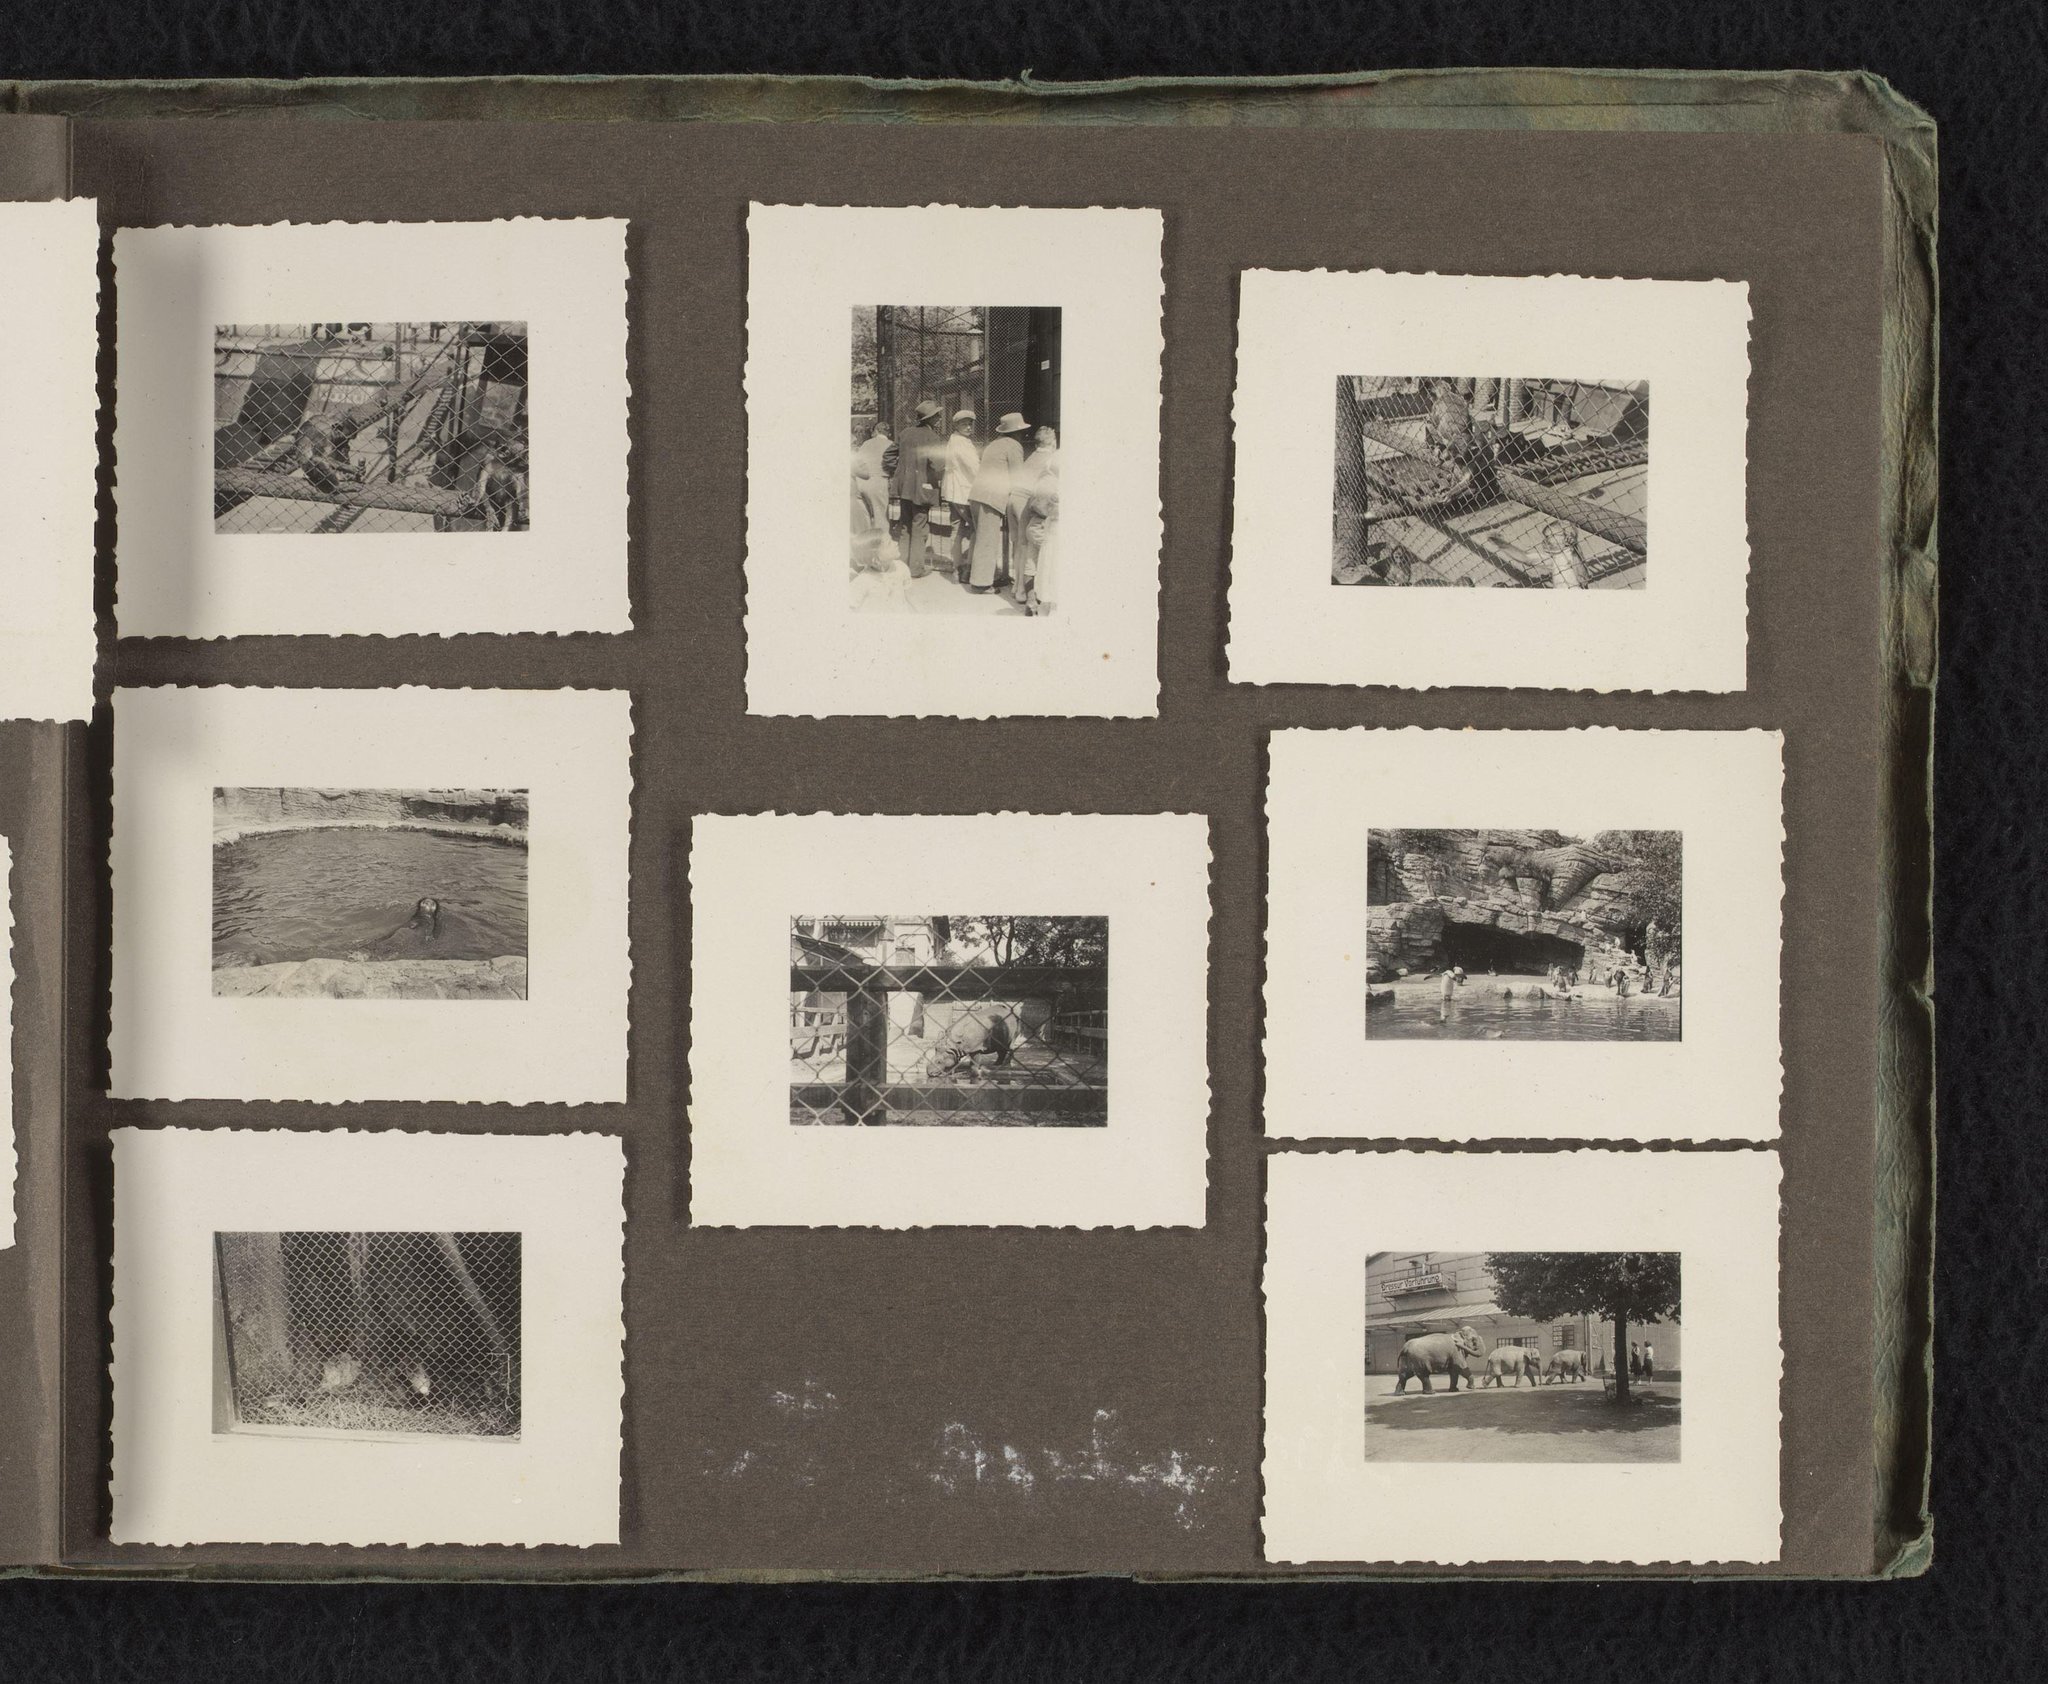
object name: photograph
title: Dieren in dierentuin Hagenbeck, juli 1933, Hamburg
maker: else wachenheimer-moos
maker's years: 1895-1944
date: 1907-1933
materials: paper, photographic support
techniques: gelatin silver print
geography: hamburg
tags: the family travelling, on holiday, zoo (as place of recreation)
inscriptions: inscription: ‘onleesbaar geschreven’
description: Blad bevat acht foto's.Zonder personen gerelateerd aan de familie Wachenheimer. Uit het album, half formaat, groen geaderd kartonomslag met koordbinding.